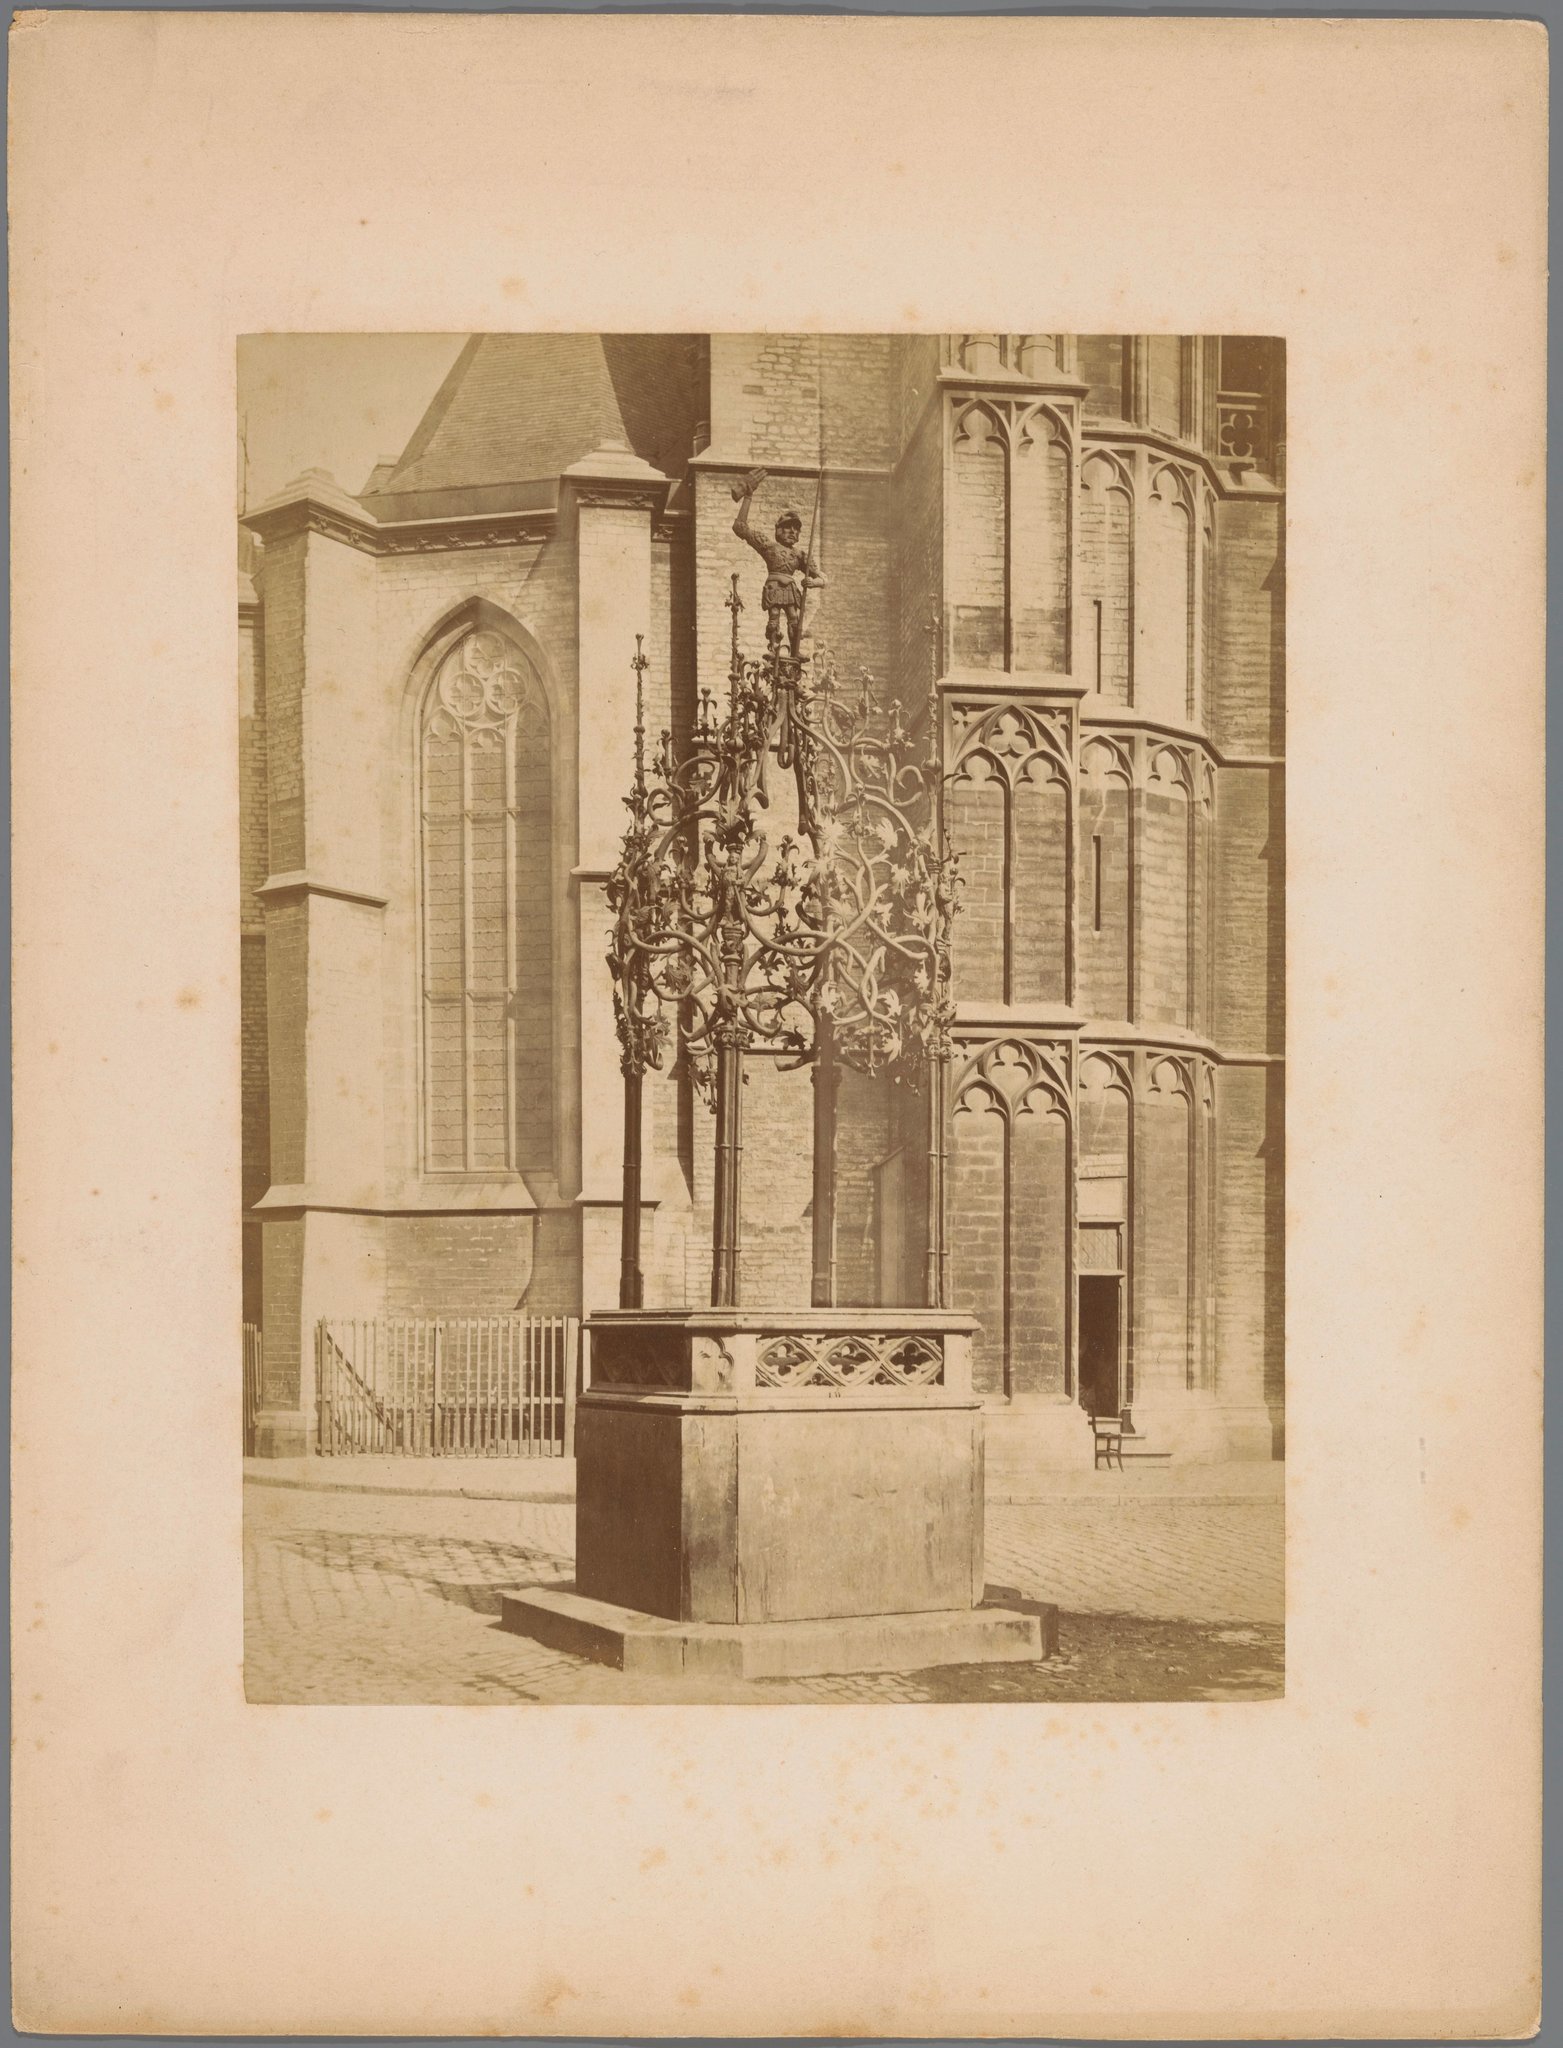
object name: photograph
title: Put van Quinten Matsijs te Antwerpen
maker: Anonymous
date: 1875-1900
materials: cardboard, photographic support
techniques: albumen print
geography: antwerp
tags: well, parts of church exterior and annexes: façade, antwerp